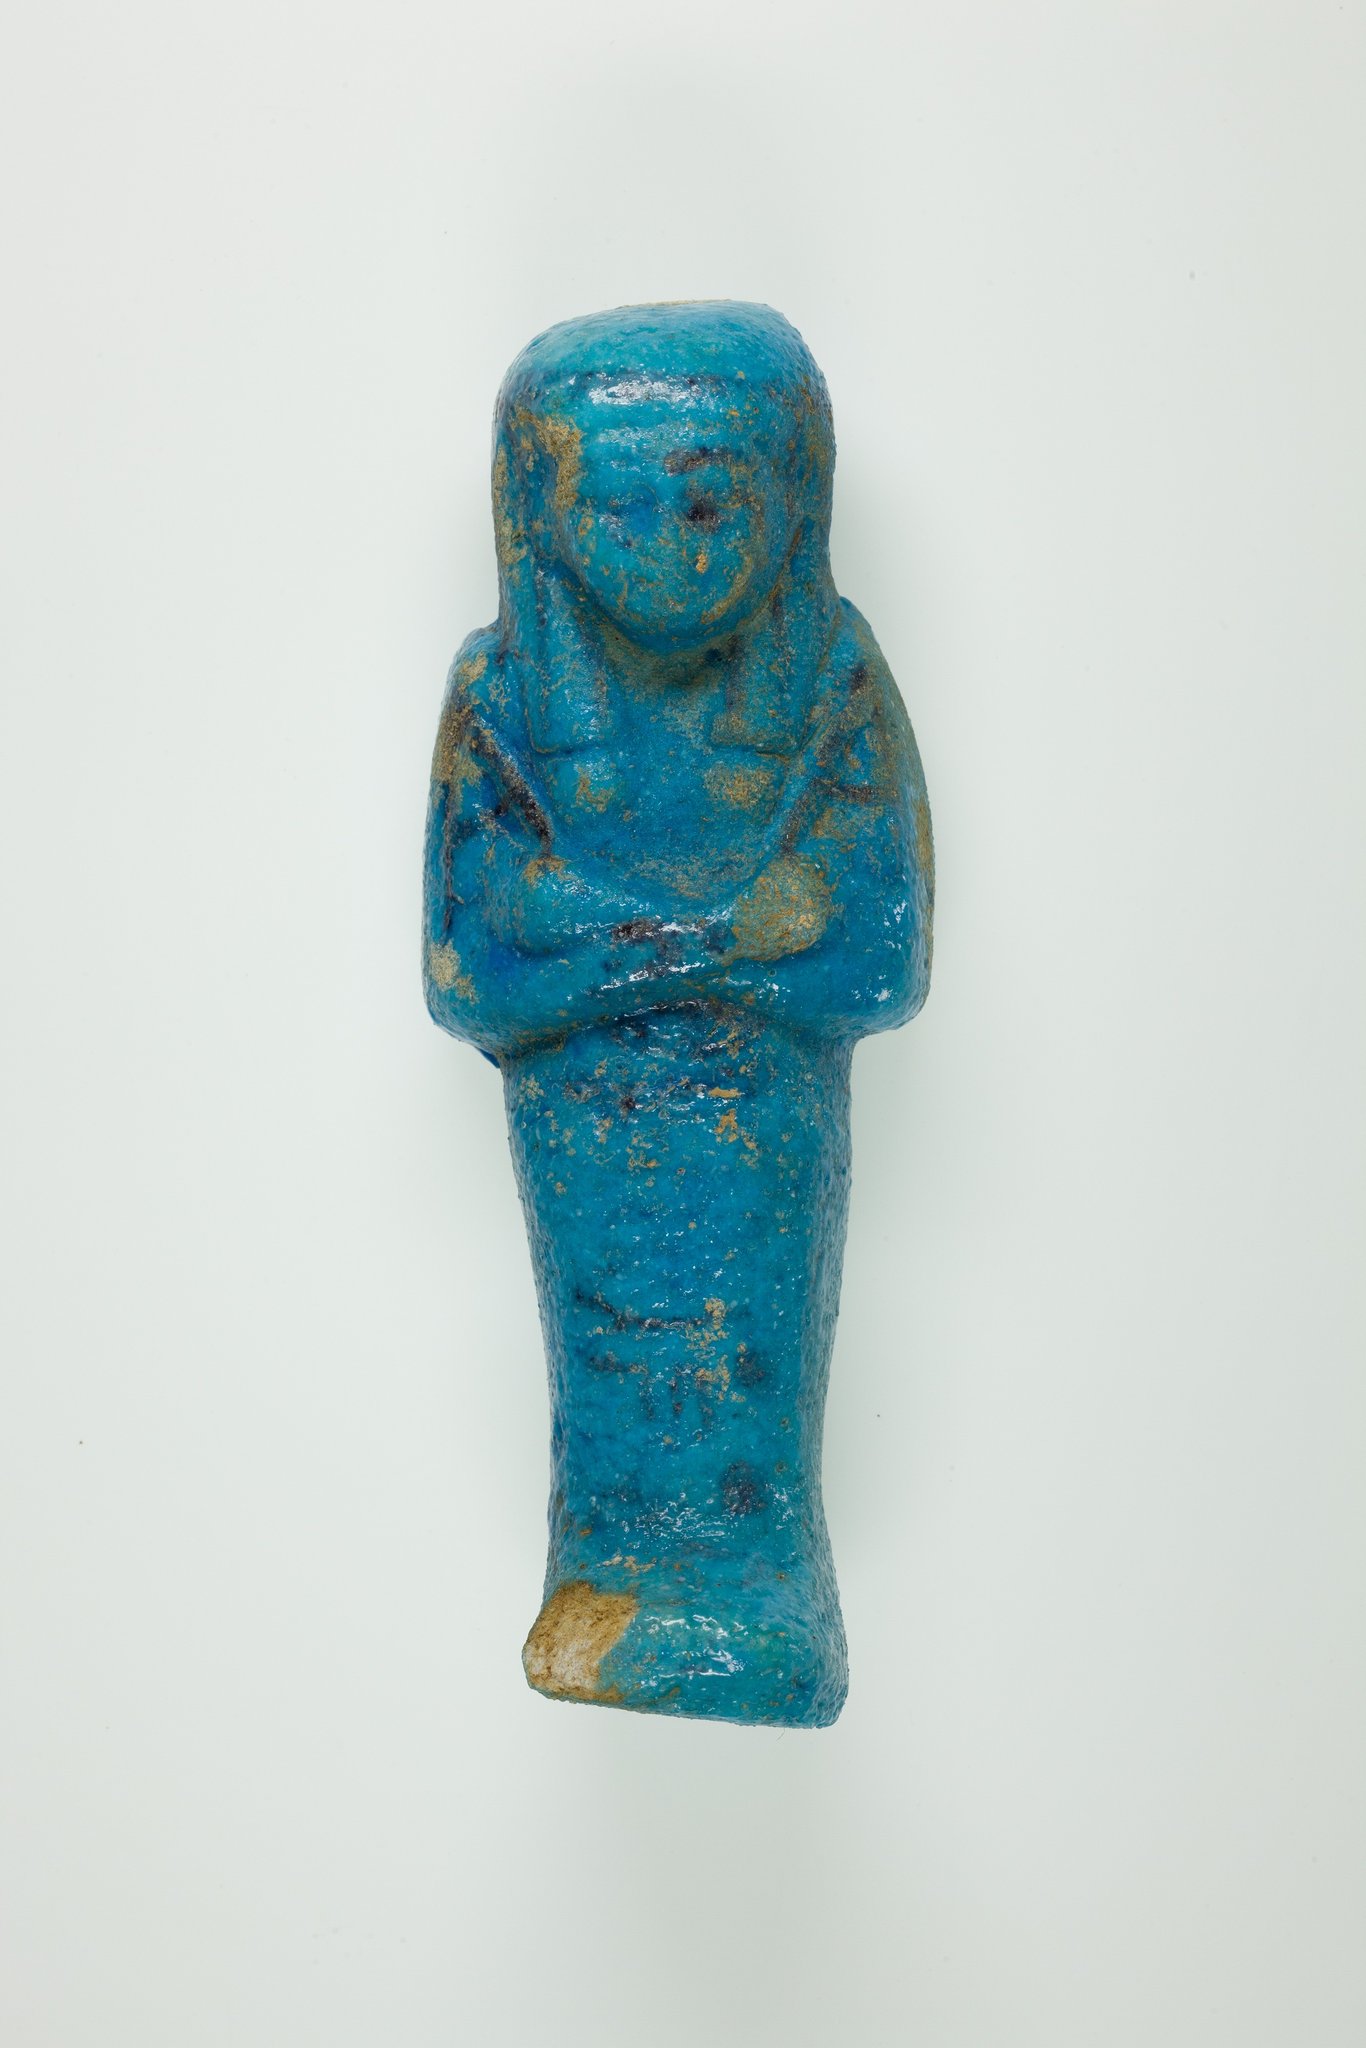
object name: worker shabti, henettawy c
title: Worker Shabti of Henettawy (C), Daughter of Isetemkheb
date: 990-970 BCE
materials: faience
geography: egypt